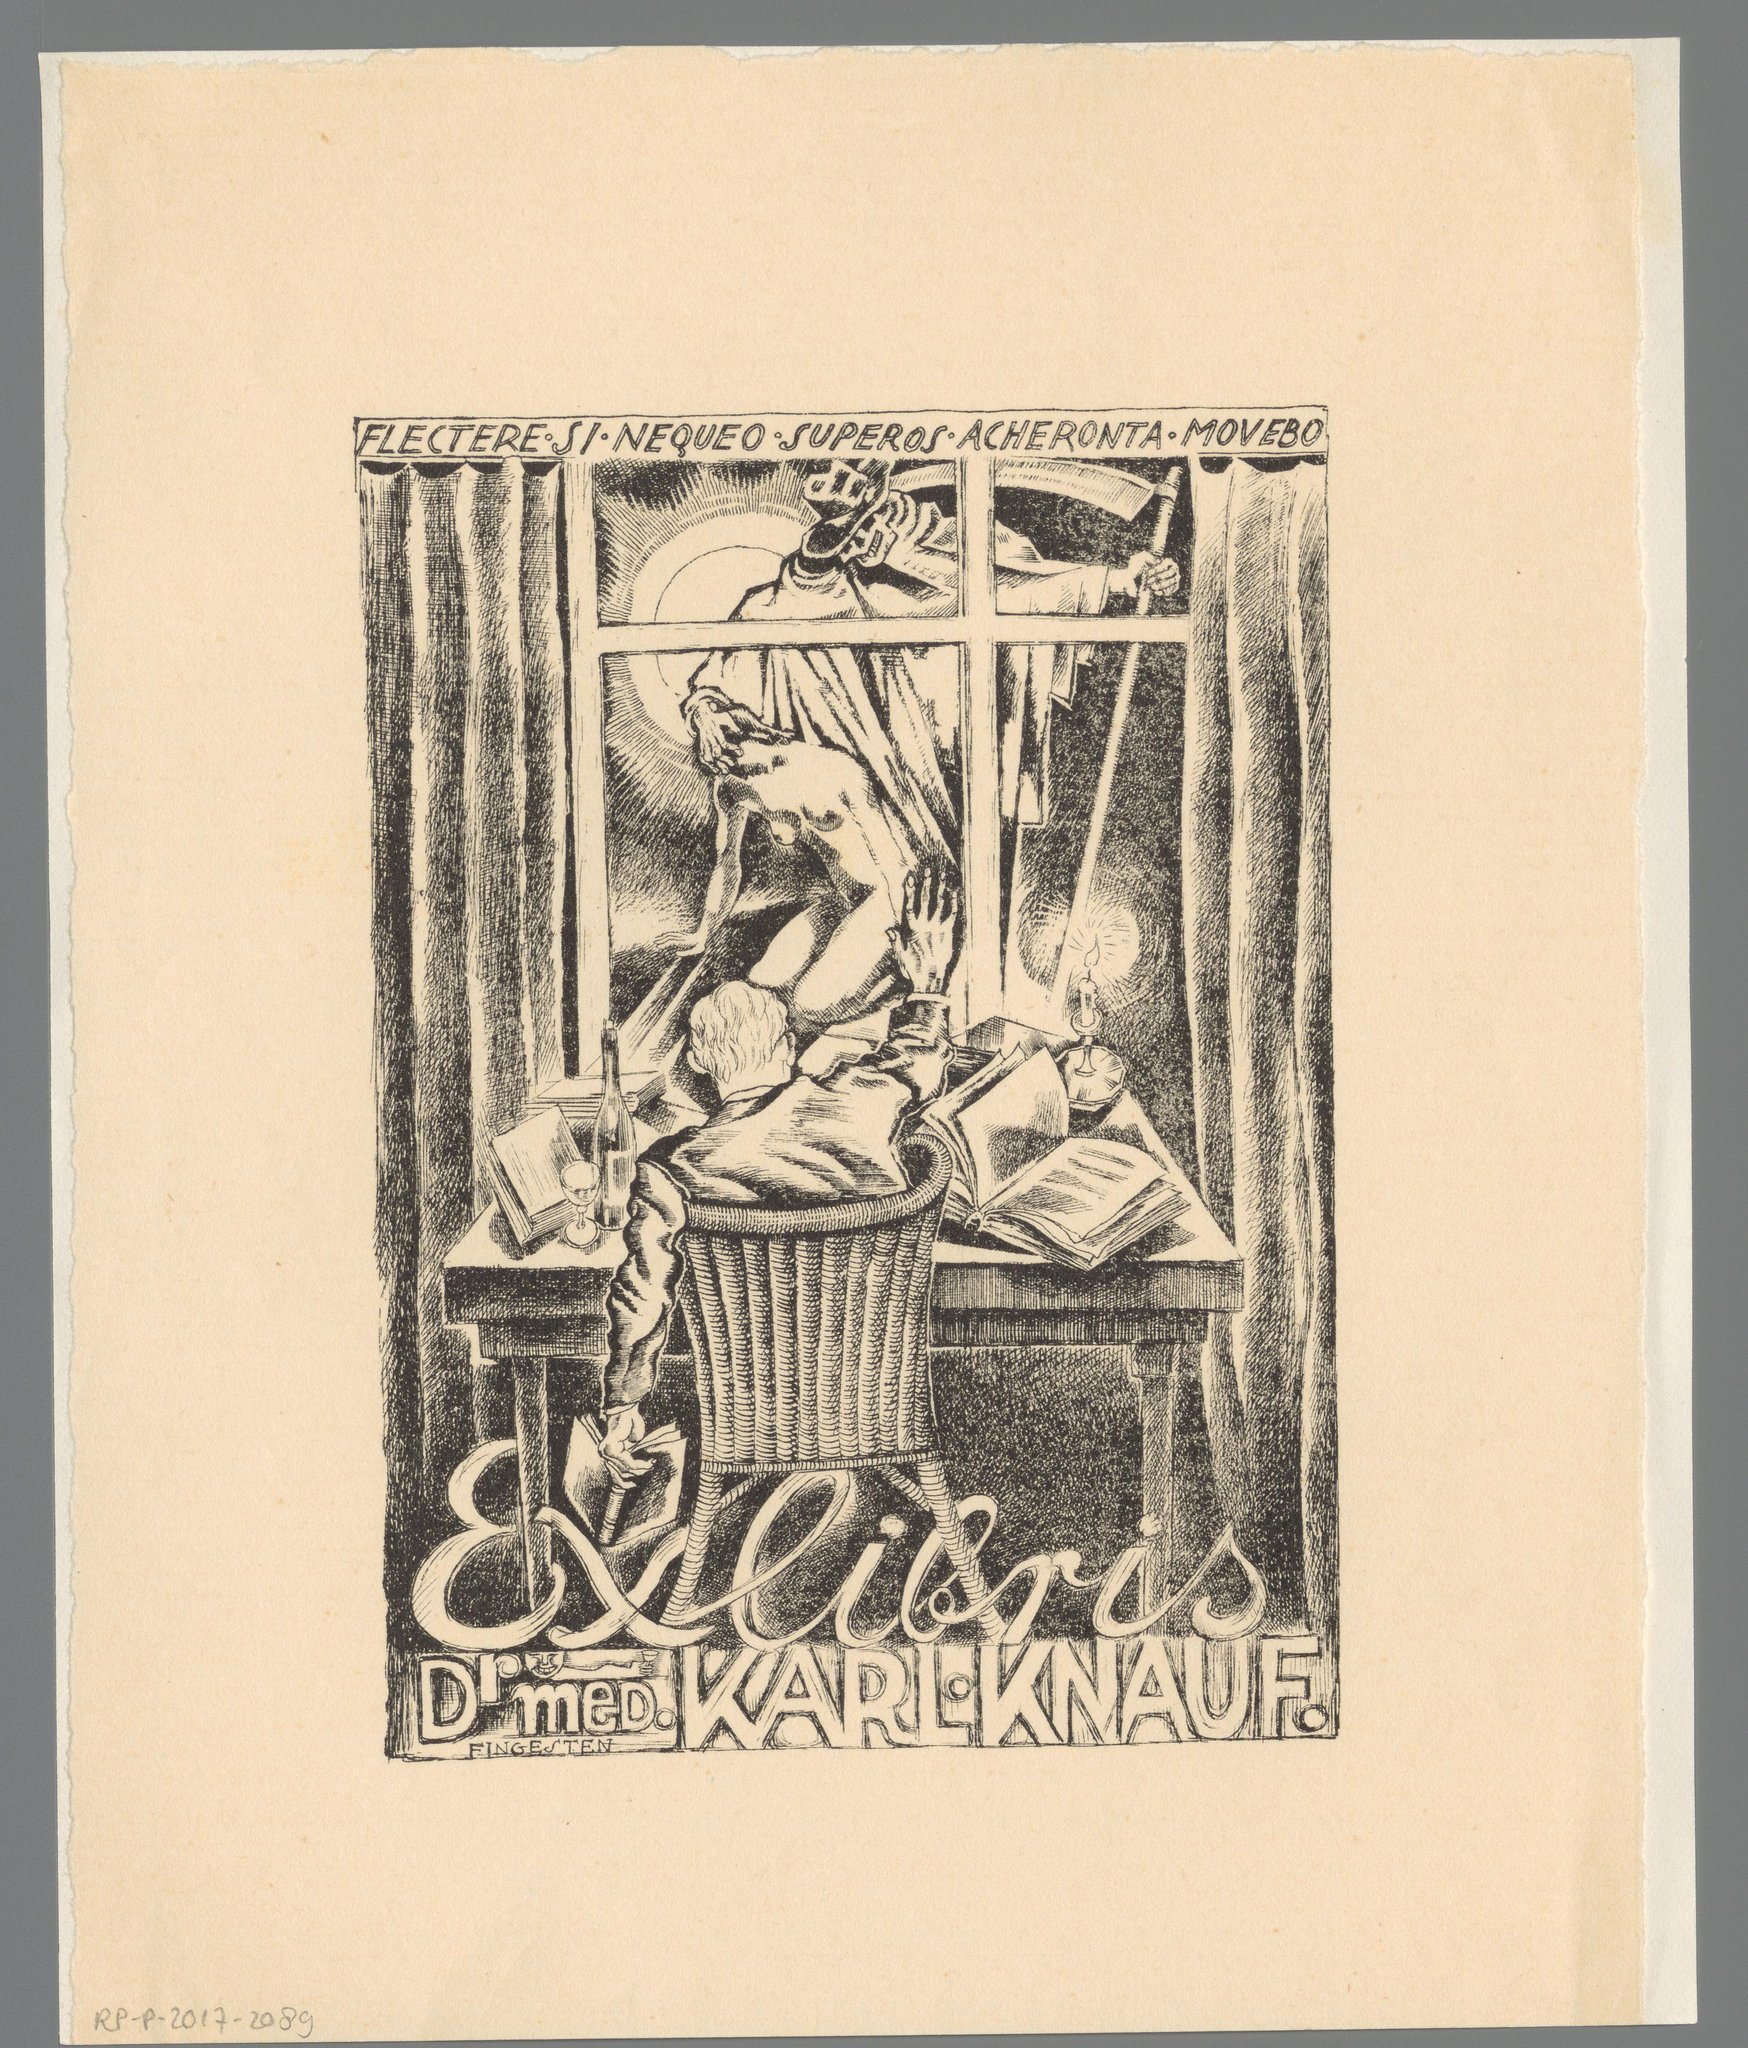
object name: bookplate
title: Flectere si nequeo superos, Acheronta movebo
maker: michel fingesten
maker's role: painter, print maker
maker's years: 1884-1943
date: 1932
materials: paper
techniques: printing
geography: italy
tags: writing-table, writing-desk, sitting figure, death as skeleton, woman (showing herself) undressed, quasi-nude, book, candle, virgil